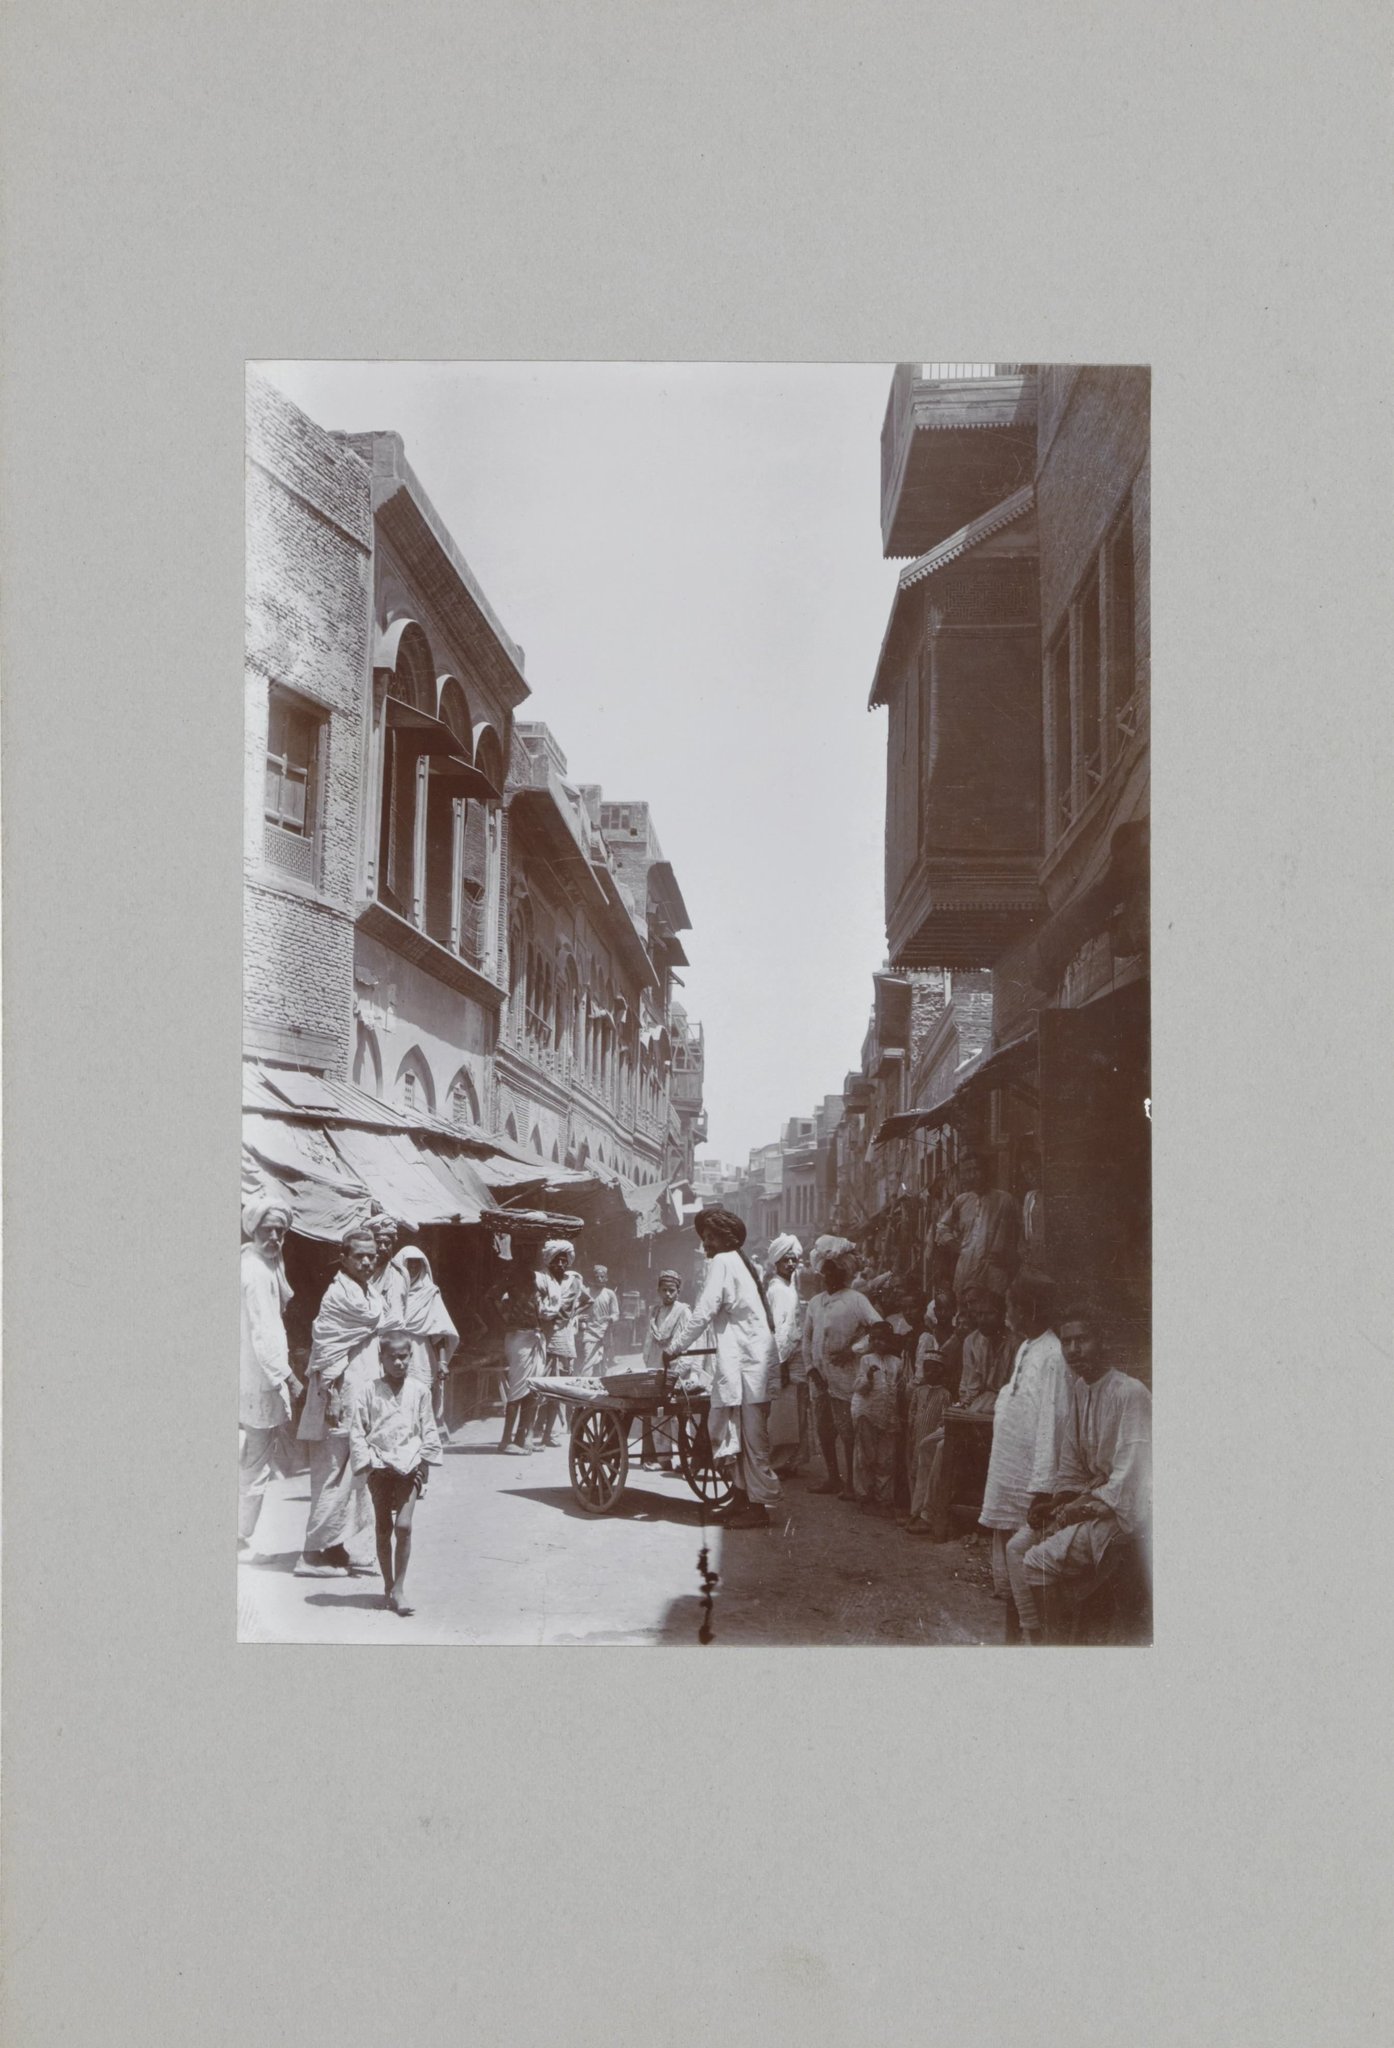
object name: photograph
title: Street view in Lahore, Punjab, Pakistan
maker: Anonymous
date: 1895-1915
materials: cardboard, paper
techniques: gelatin silver print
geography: lahore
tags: lahore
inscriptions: annotation: ‘17b Straat in Lahore.’